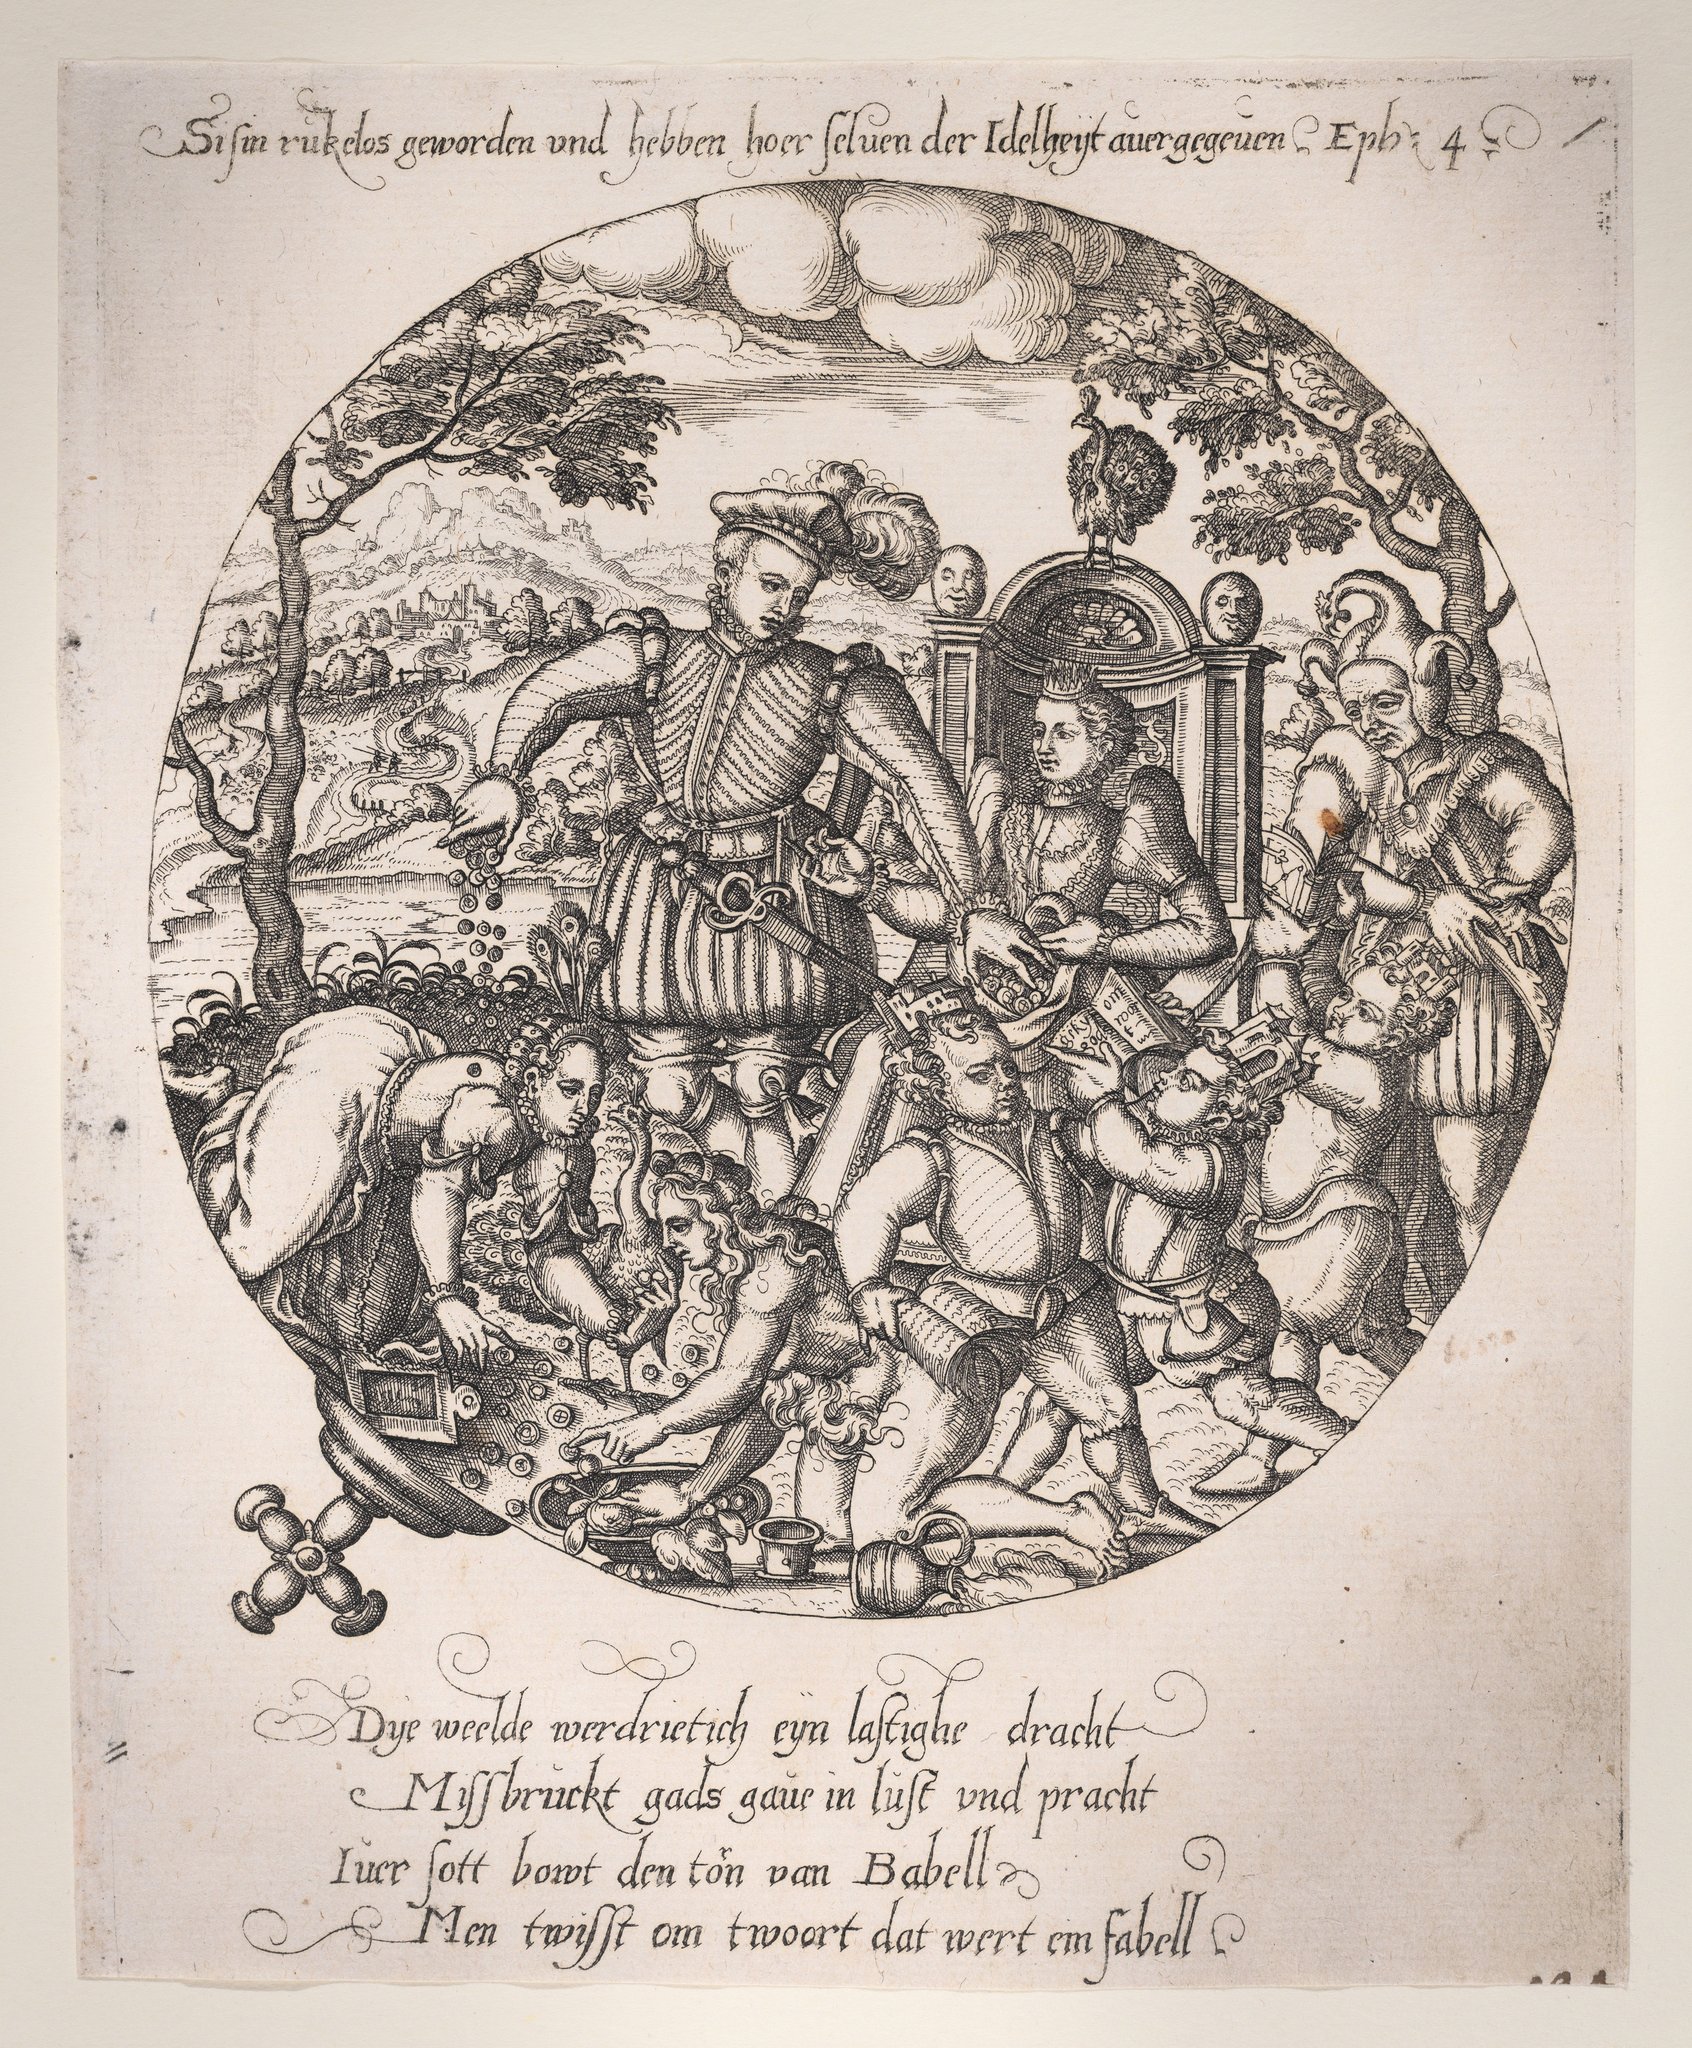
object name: print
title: They have become foolhardy and have given themselves over to vanity (Ephesians 4:19), plate 2 from a series of Four Allegories of the Netherlands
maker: anonymous, netherlandish, 16th century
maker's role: artist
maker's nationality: netherlandish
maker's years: 1500-1600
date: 1570-1572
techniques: etching